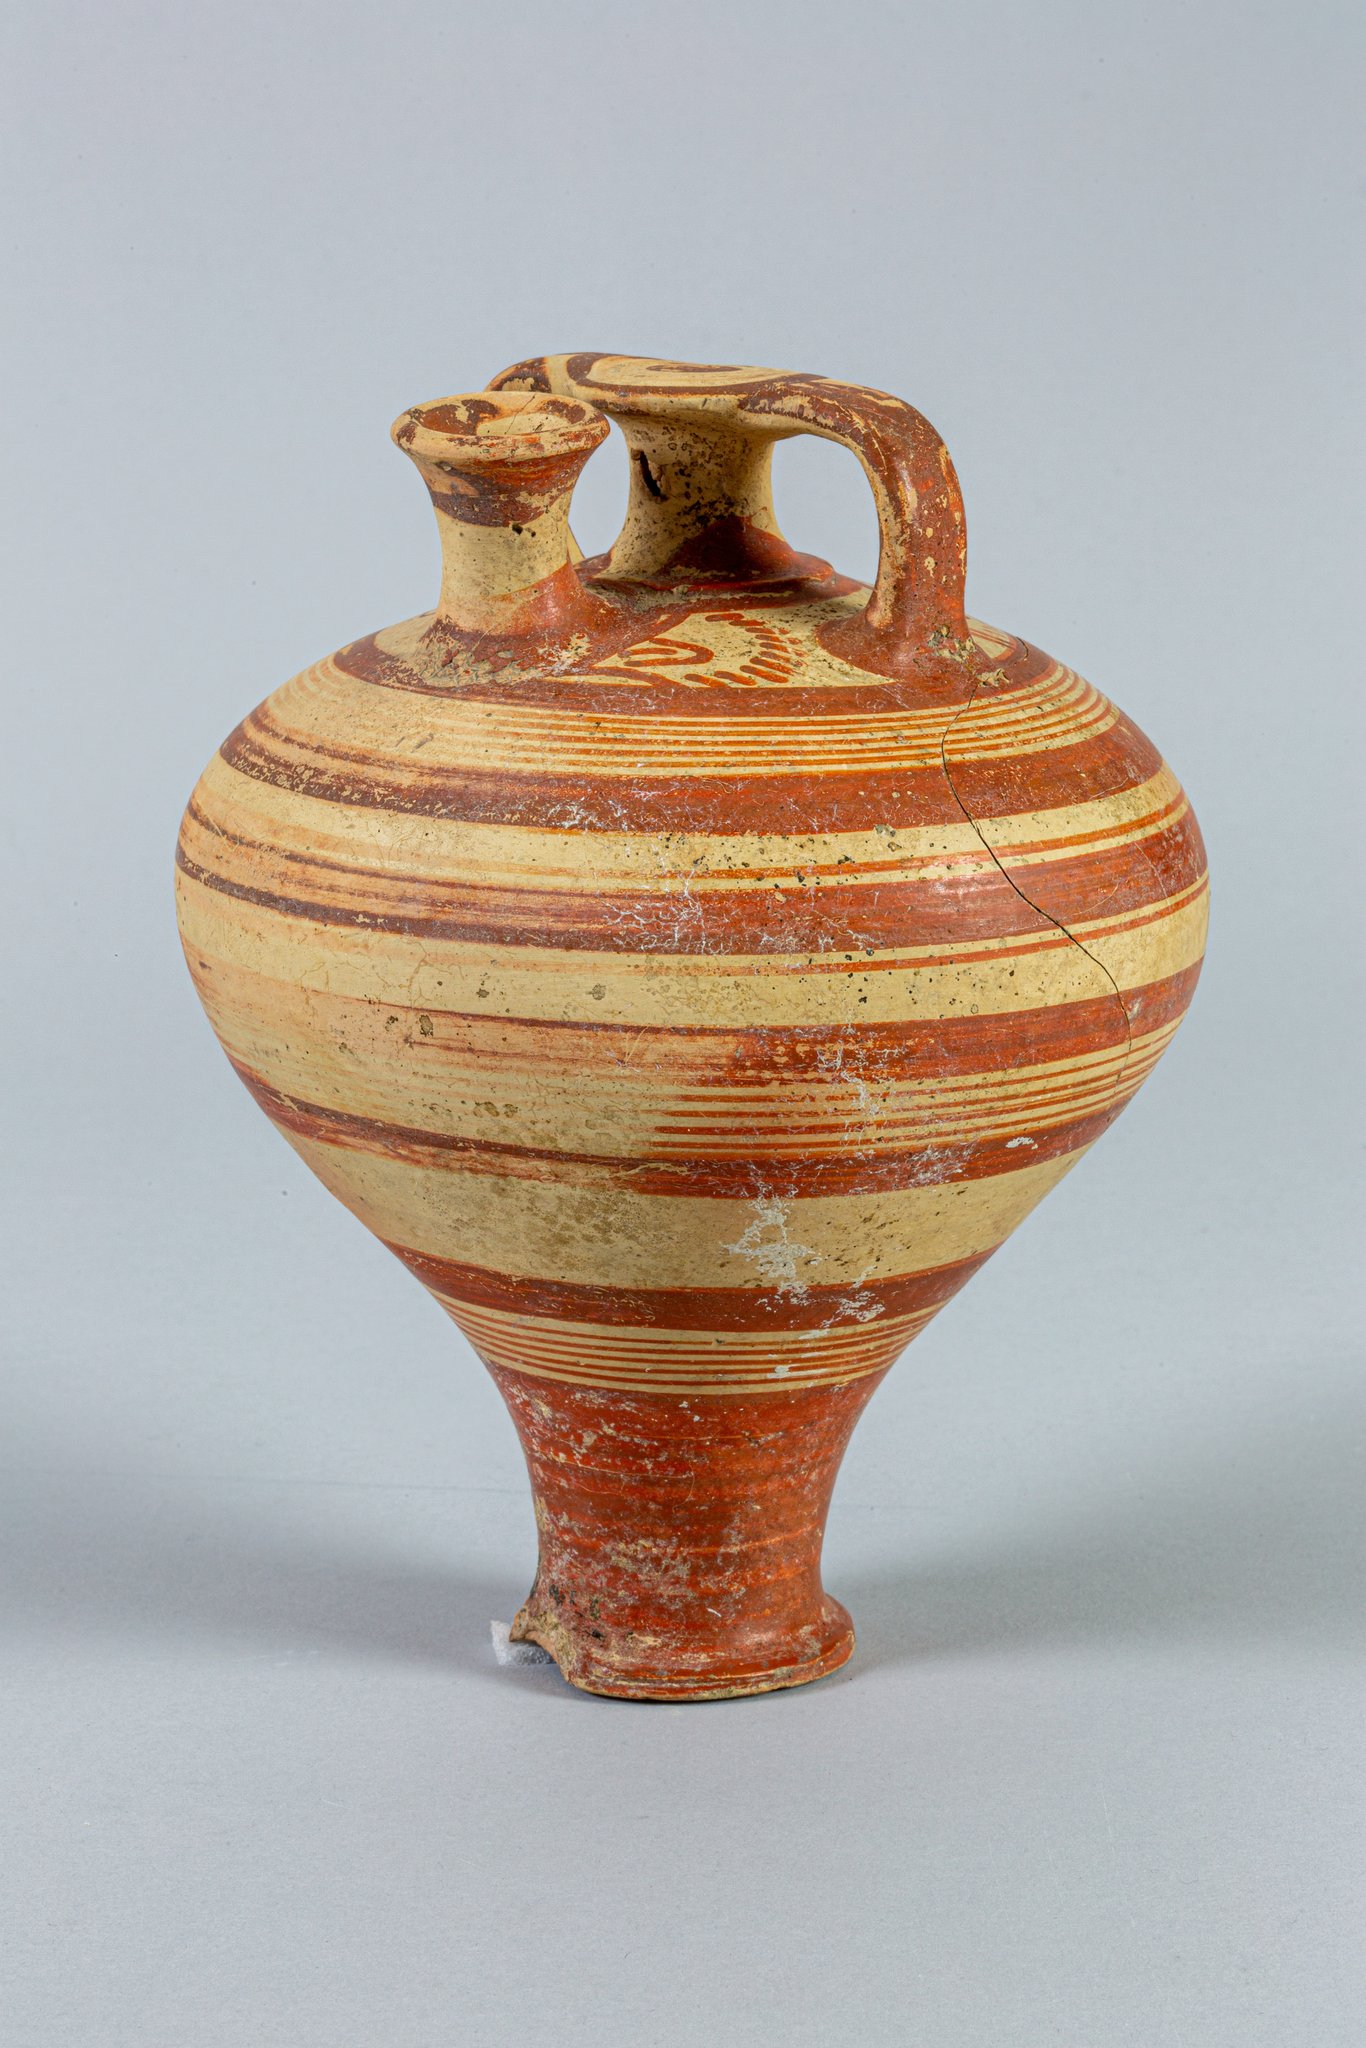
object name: stirrup jar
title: Terracotta stirrup jar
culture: mycenaean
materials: terracotta